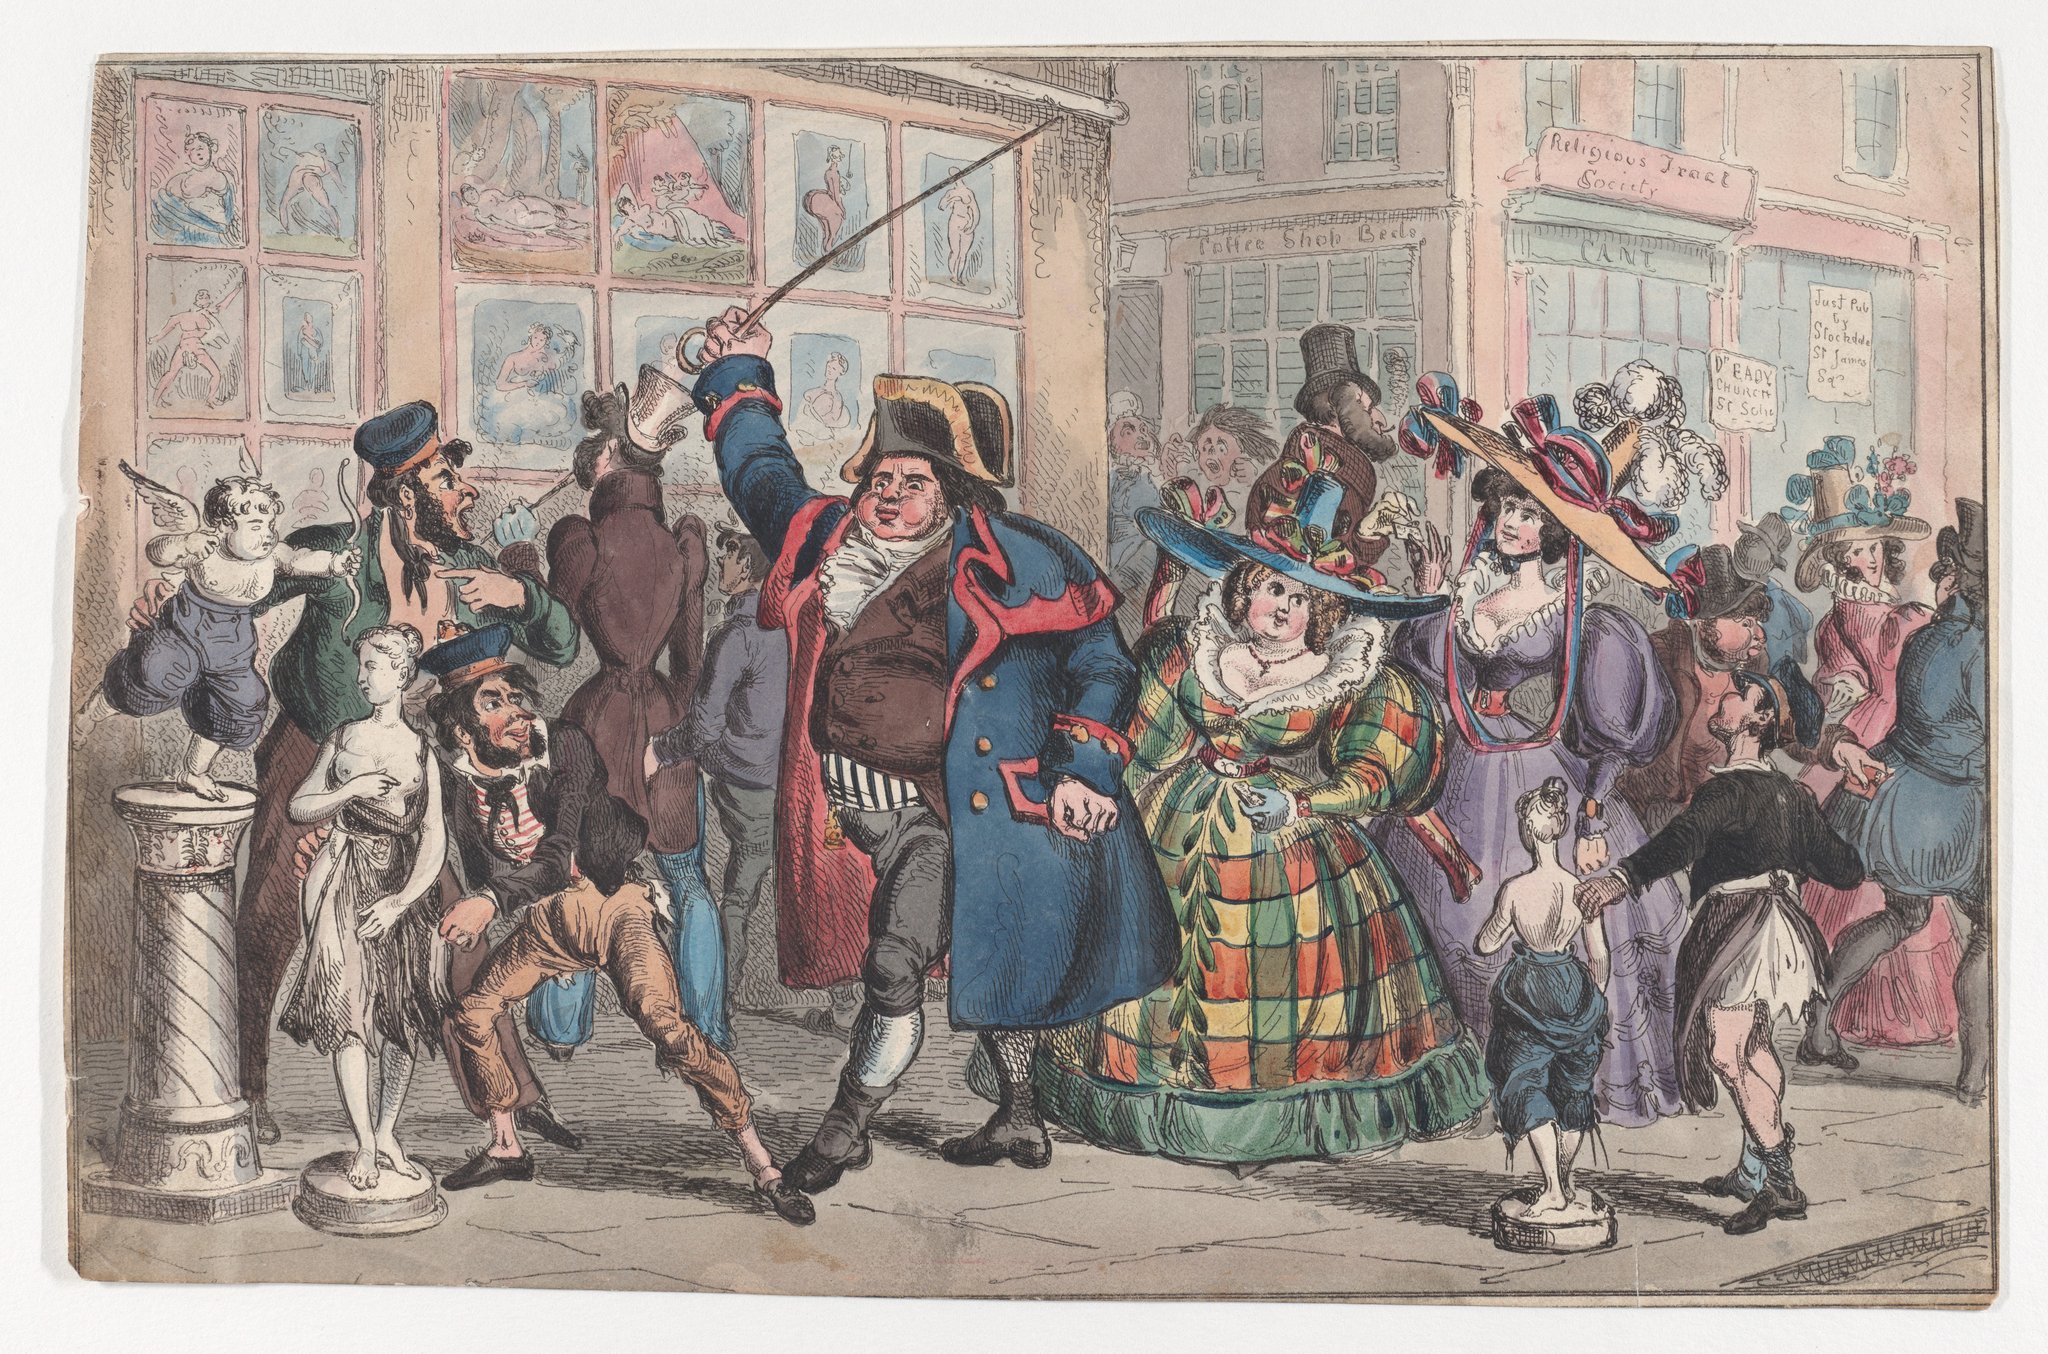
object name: print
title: The March of Morality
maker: william heath ('paul pry')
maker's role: artist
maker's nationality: british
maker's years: 1794-1840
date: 1827-1829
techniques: etching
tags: satire,men,women